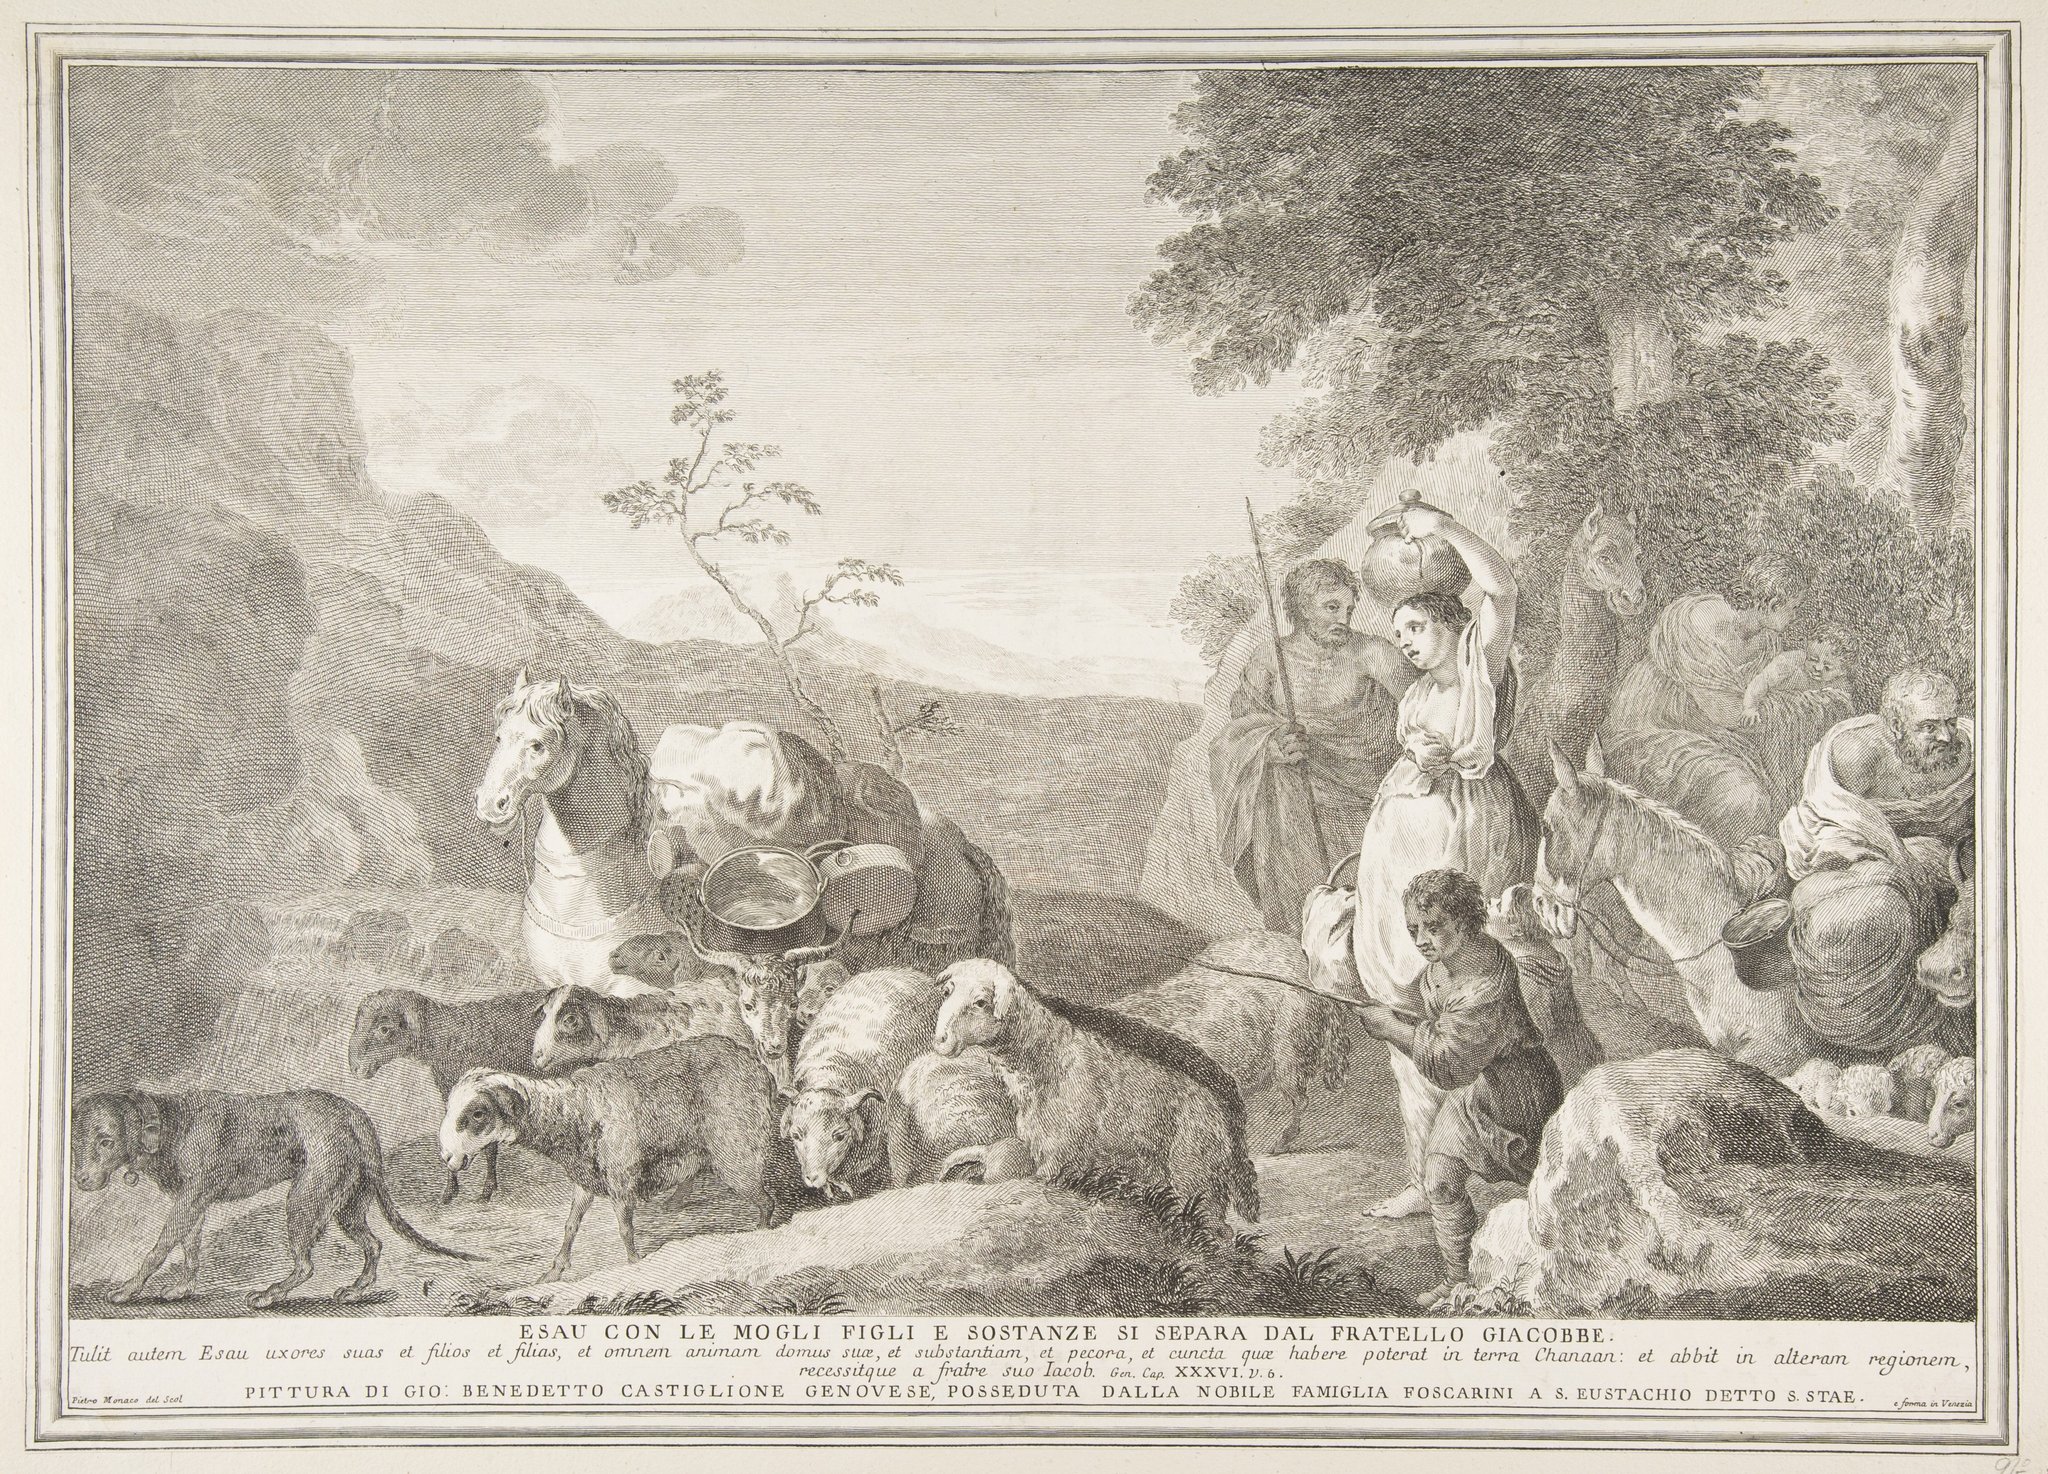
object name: print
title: Esau and his family parting ways with Jacob (Esau con le mogli figli e sostanze si separa dal fratello Giacobbe)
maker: pietro monaco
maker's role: artist and publisher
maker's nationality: italian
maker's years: 1707-1772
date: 1743-1763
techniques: etching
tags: children,men,women,horses,sheep